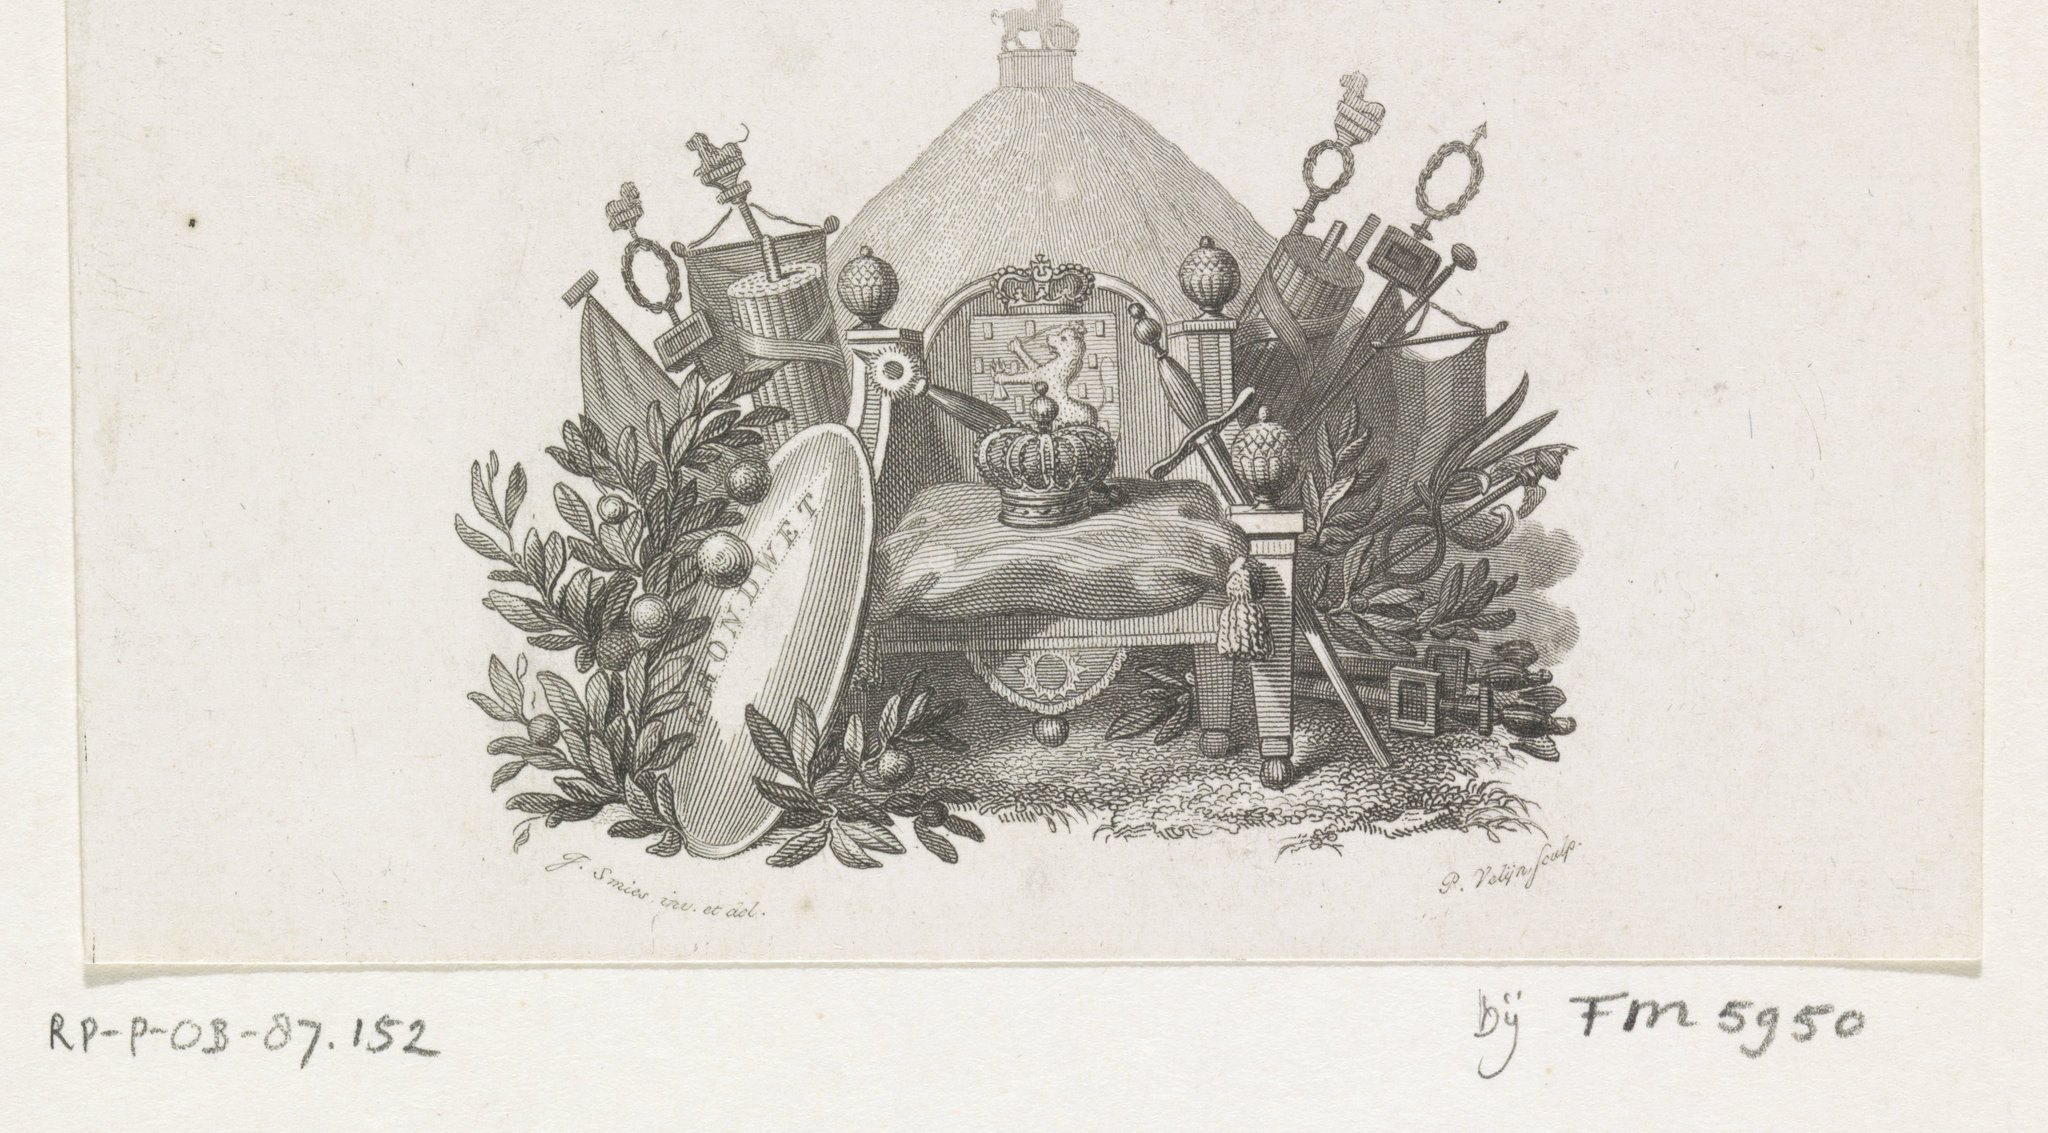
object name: print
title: Vignet met symbolen van koning Willem I, 1815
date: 1826-1836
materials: paper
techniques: engraving, etching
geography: netherlands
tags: the hague, berlin, william i of the netherlands, monarchy; 'monarchia mondana' (ripa), insignia and symbols of sovereignty (crown, diadem, sceptre, orb, seal, standard, cloak, pectoral)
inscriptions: collector's mark: Lugt 2228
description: Vignet met de regalia, de symbolen van het koningschap van koning Willem I, de grondwet en op de achtergrond de Leeuw van Waterloo, het herdenkingsmonument voor de slag bij Waterloo van 1815, opgericht op bevel van koning Willem I tussen 1823-1826.